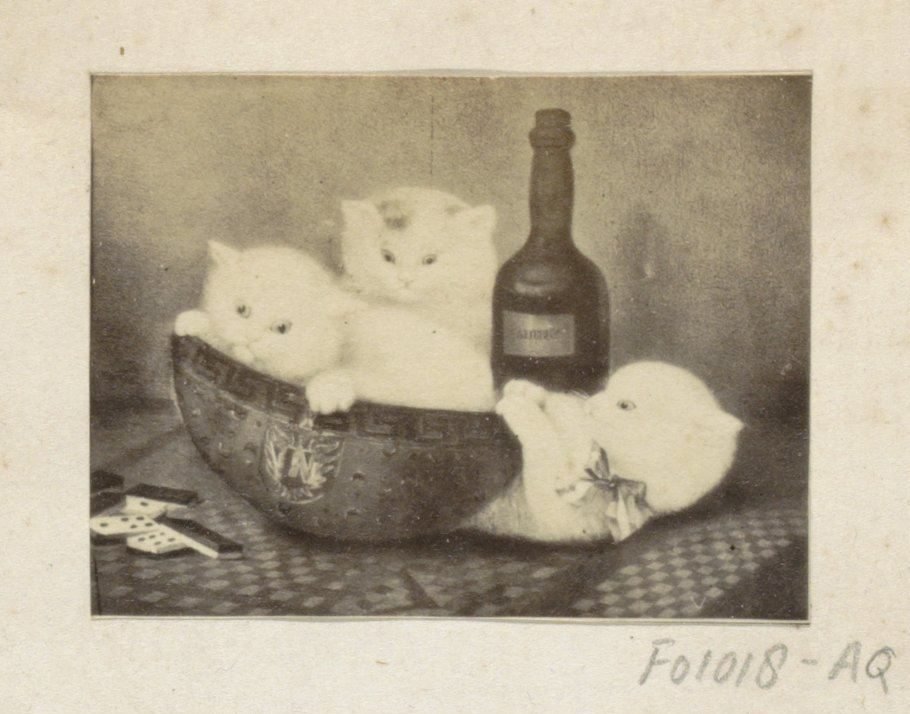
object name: reproduction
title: Fotoreproductie van (vermoedelijk) een schilderij met drie katten, een kaas en een fles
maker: Anonymous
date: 1860-1870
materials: paper, photographic support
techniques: albumen print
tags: cat, container of glass: bottle, jar, vase, cheese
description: Onderdeel van Engels familiealbum met foto's van personen, reizen, cricket en kunstwerken.